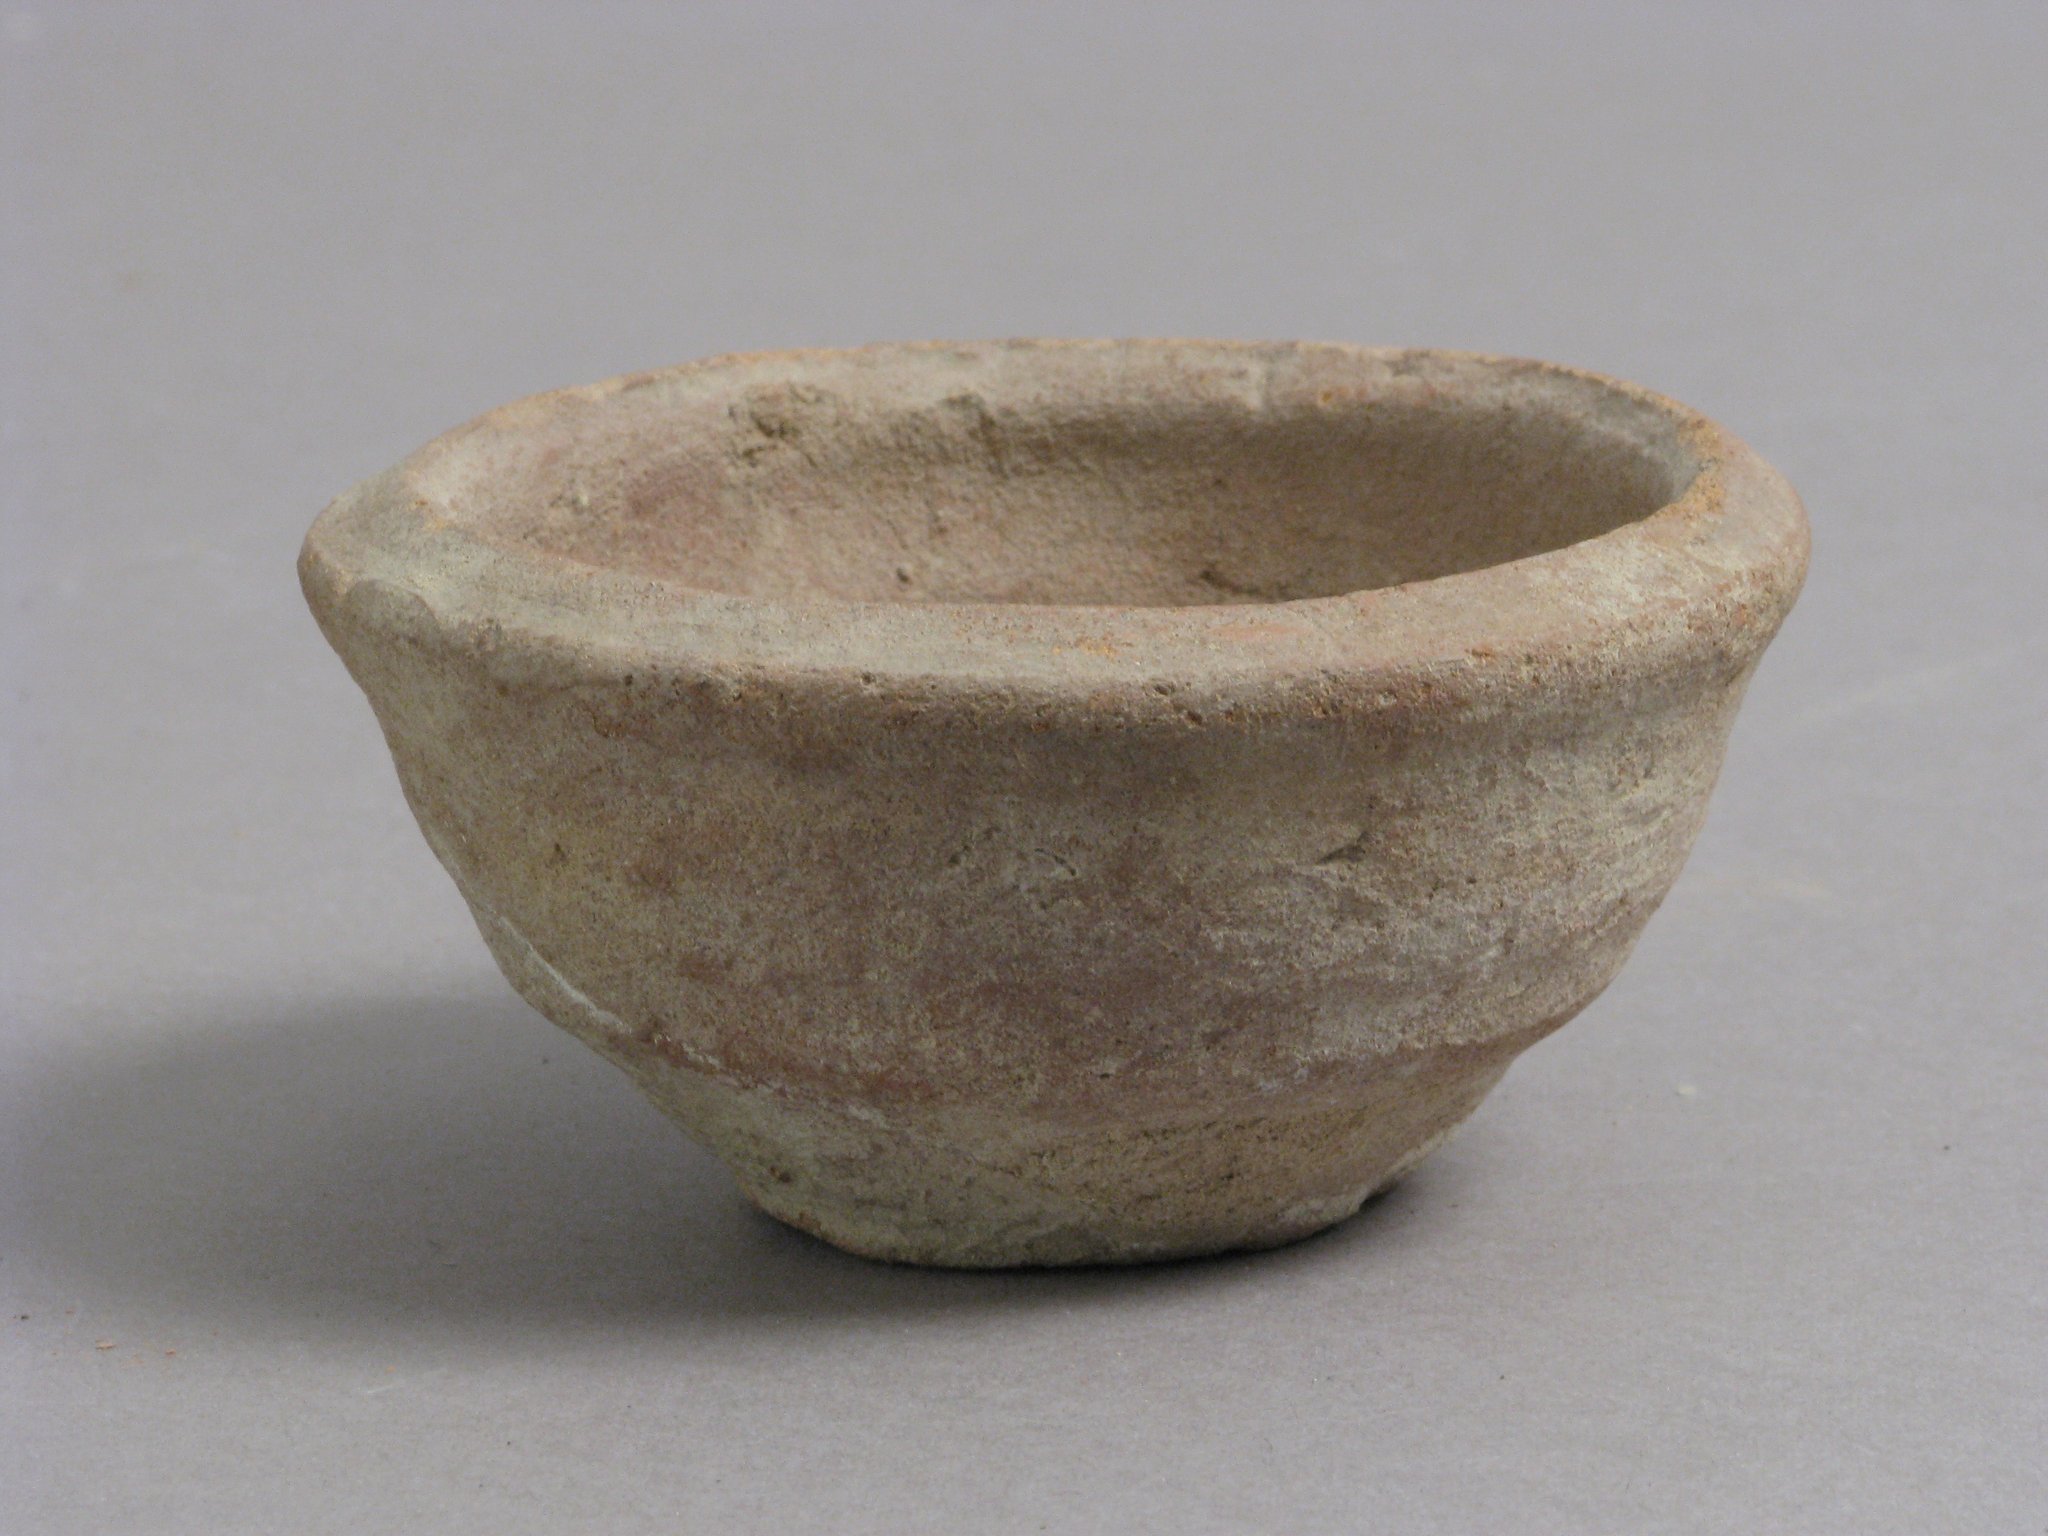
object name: bowl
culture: coptic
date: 301-700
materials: earthenware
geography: egypt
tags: bowls